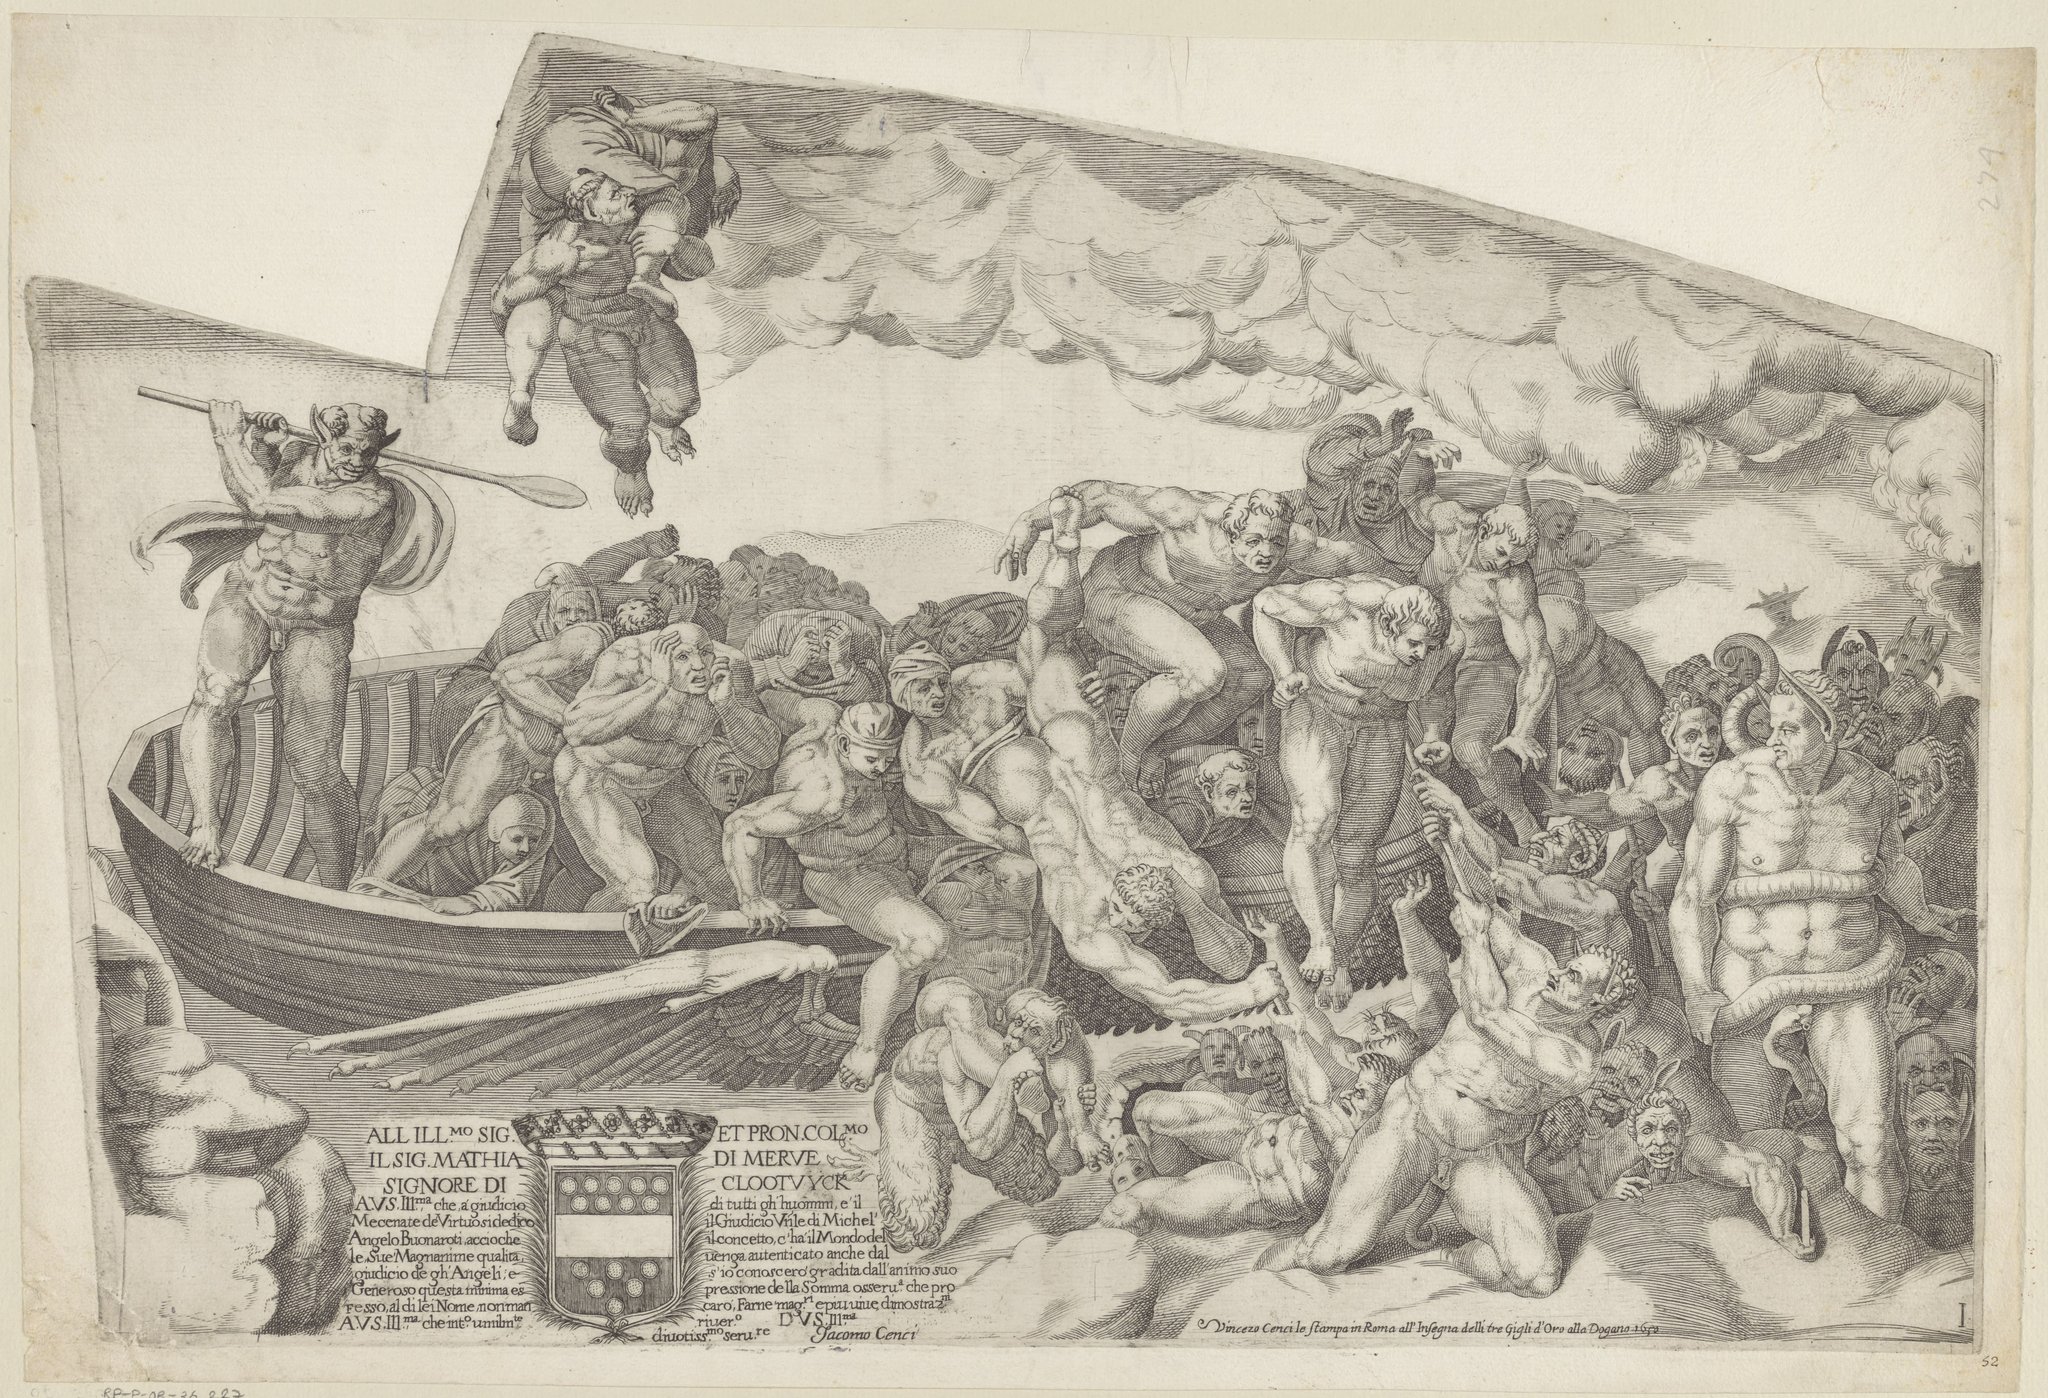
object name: print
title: Het laatste oordeel, blad I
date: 1530-1582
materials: paper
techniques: engraving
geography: rome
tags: last judgement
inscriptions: collector's mark: Lugt 240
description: Prent maakt deel uit van een groep van tien prenten die samen één grote voorstelling vormen naar het fresco met het Laatste Oordeel door Michelangelo in de Sixtijnse Kapel in het Vaticaan.